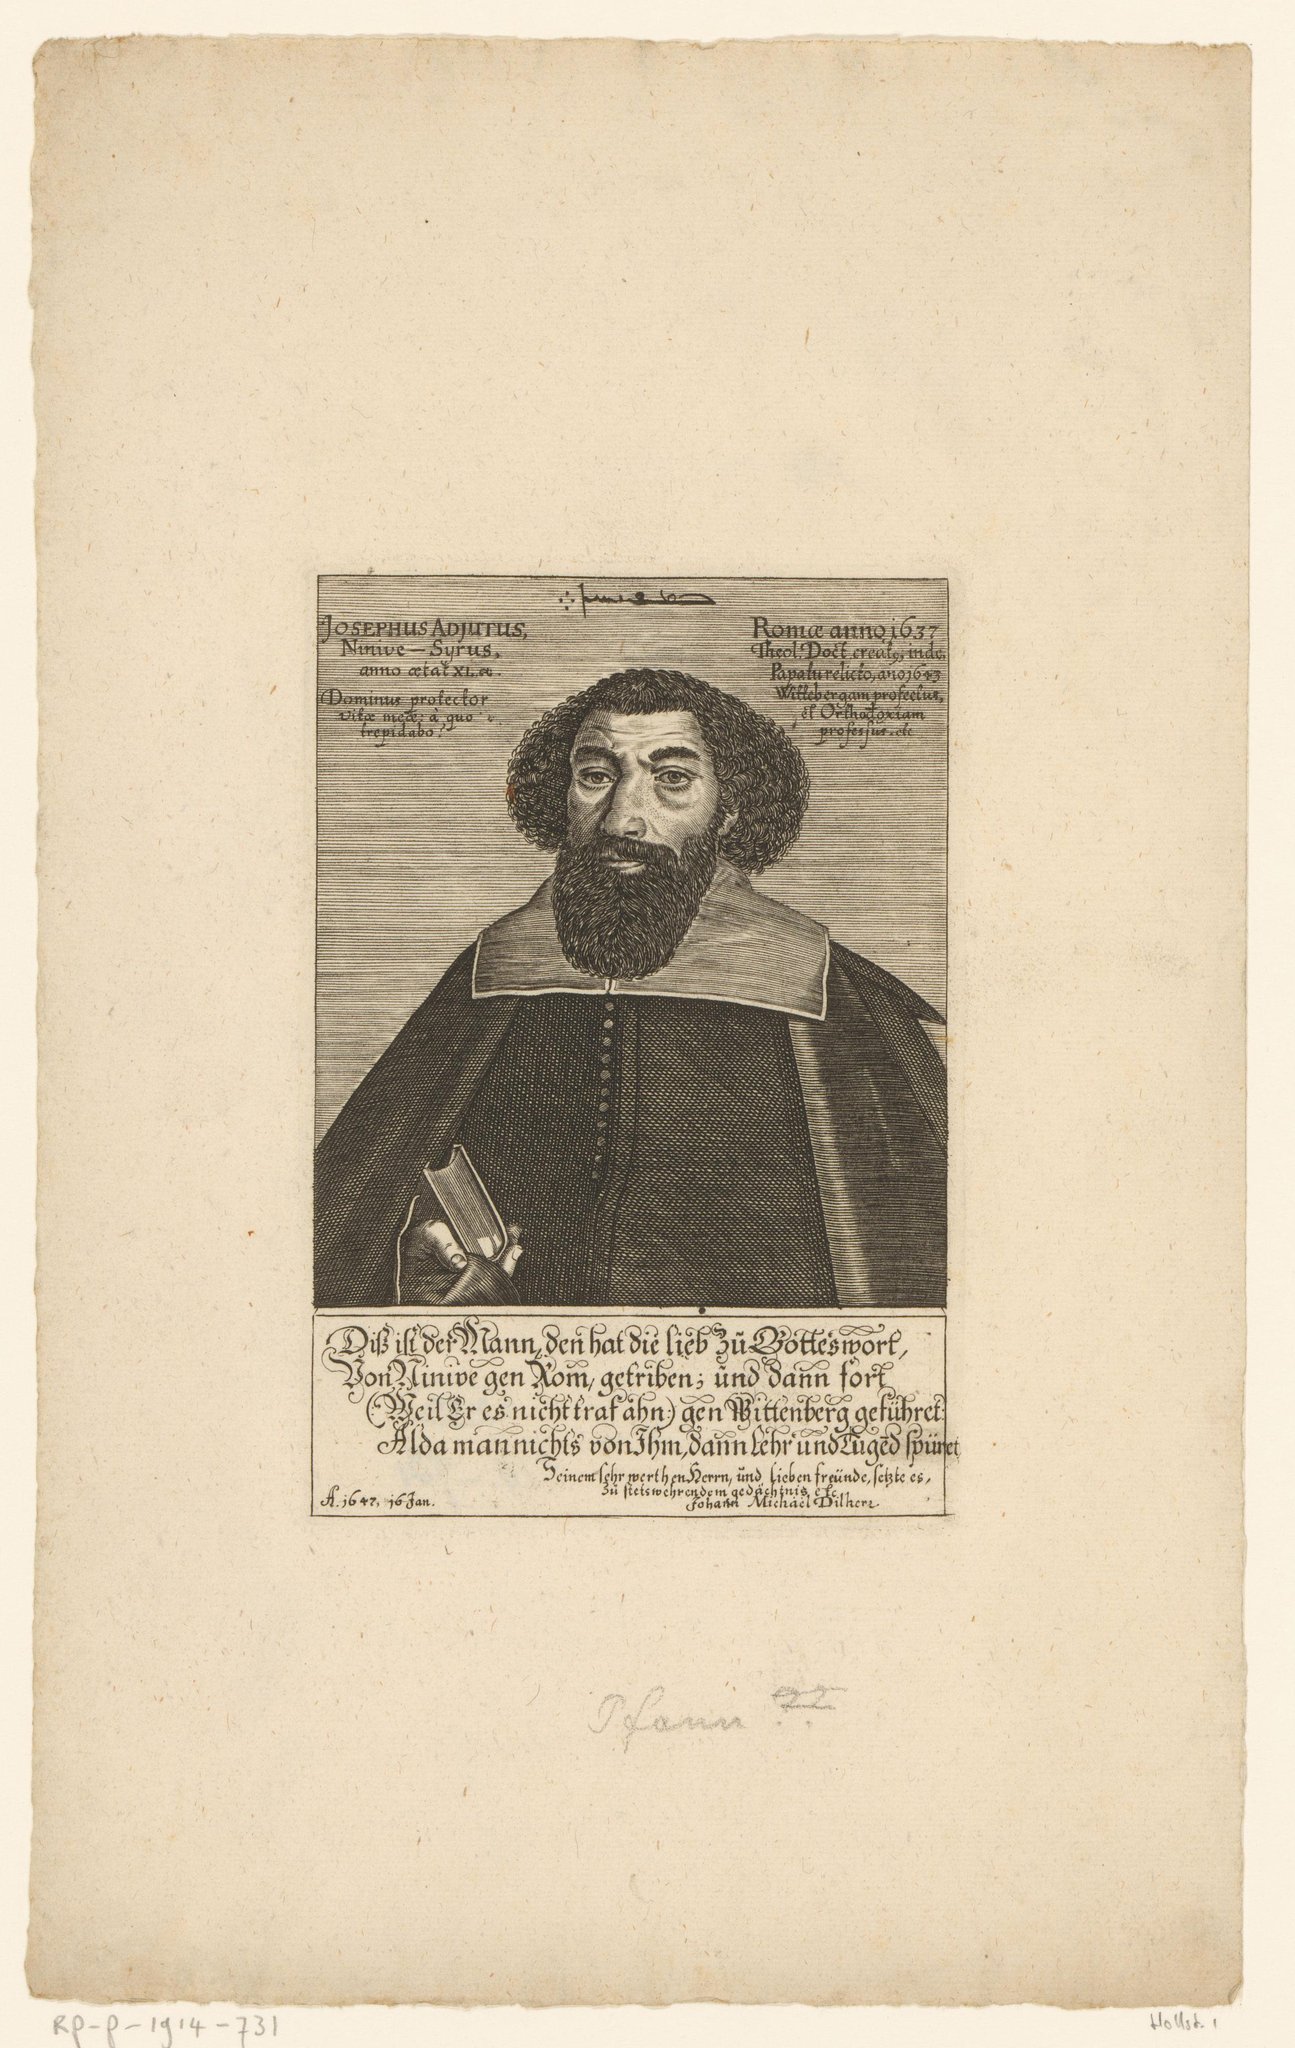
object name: print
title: Portret van Josephus Adjutus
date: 1648-1663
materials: paper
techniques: engraving, etching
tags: historical persons, armorial bearing, heraldry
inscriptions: : ‘Pfann 22’, collector's mark: Lugt 2228